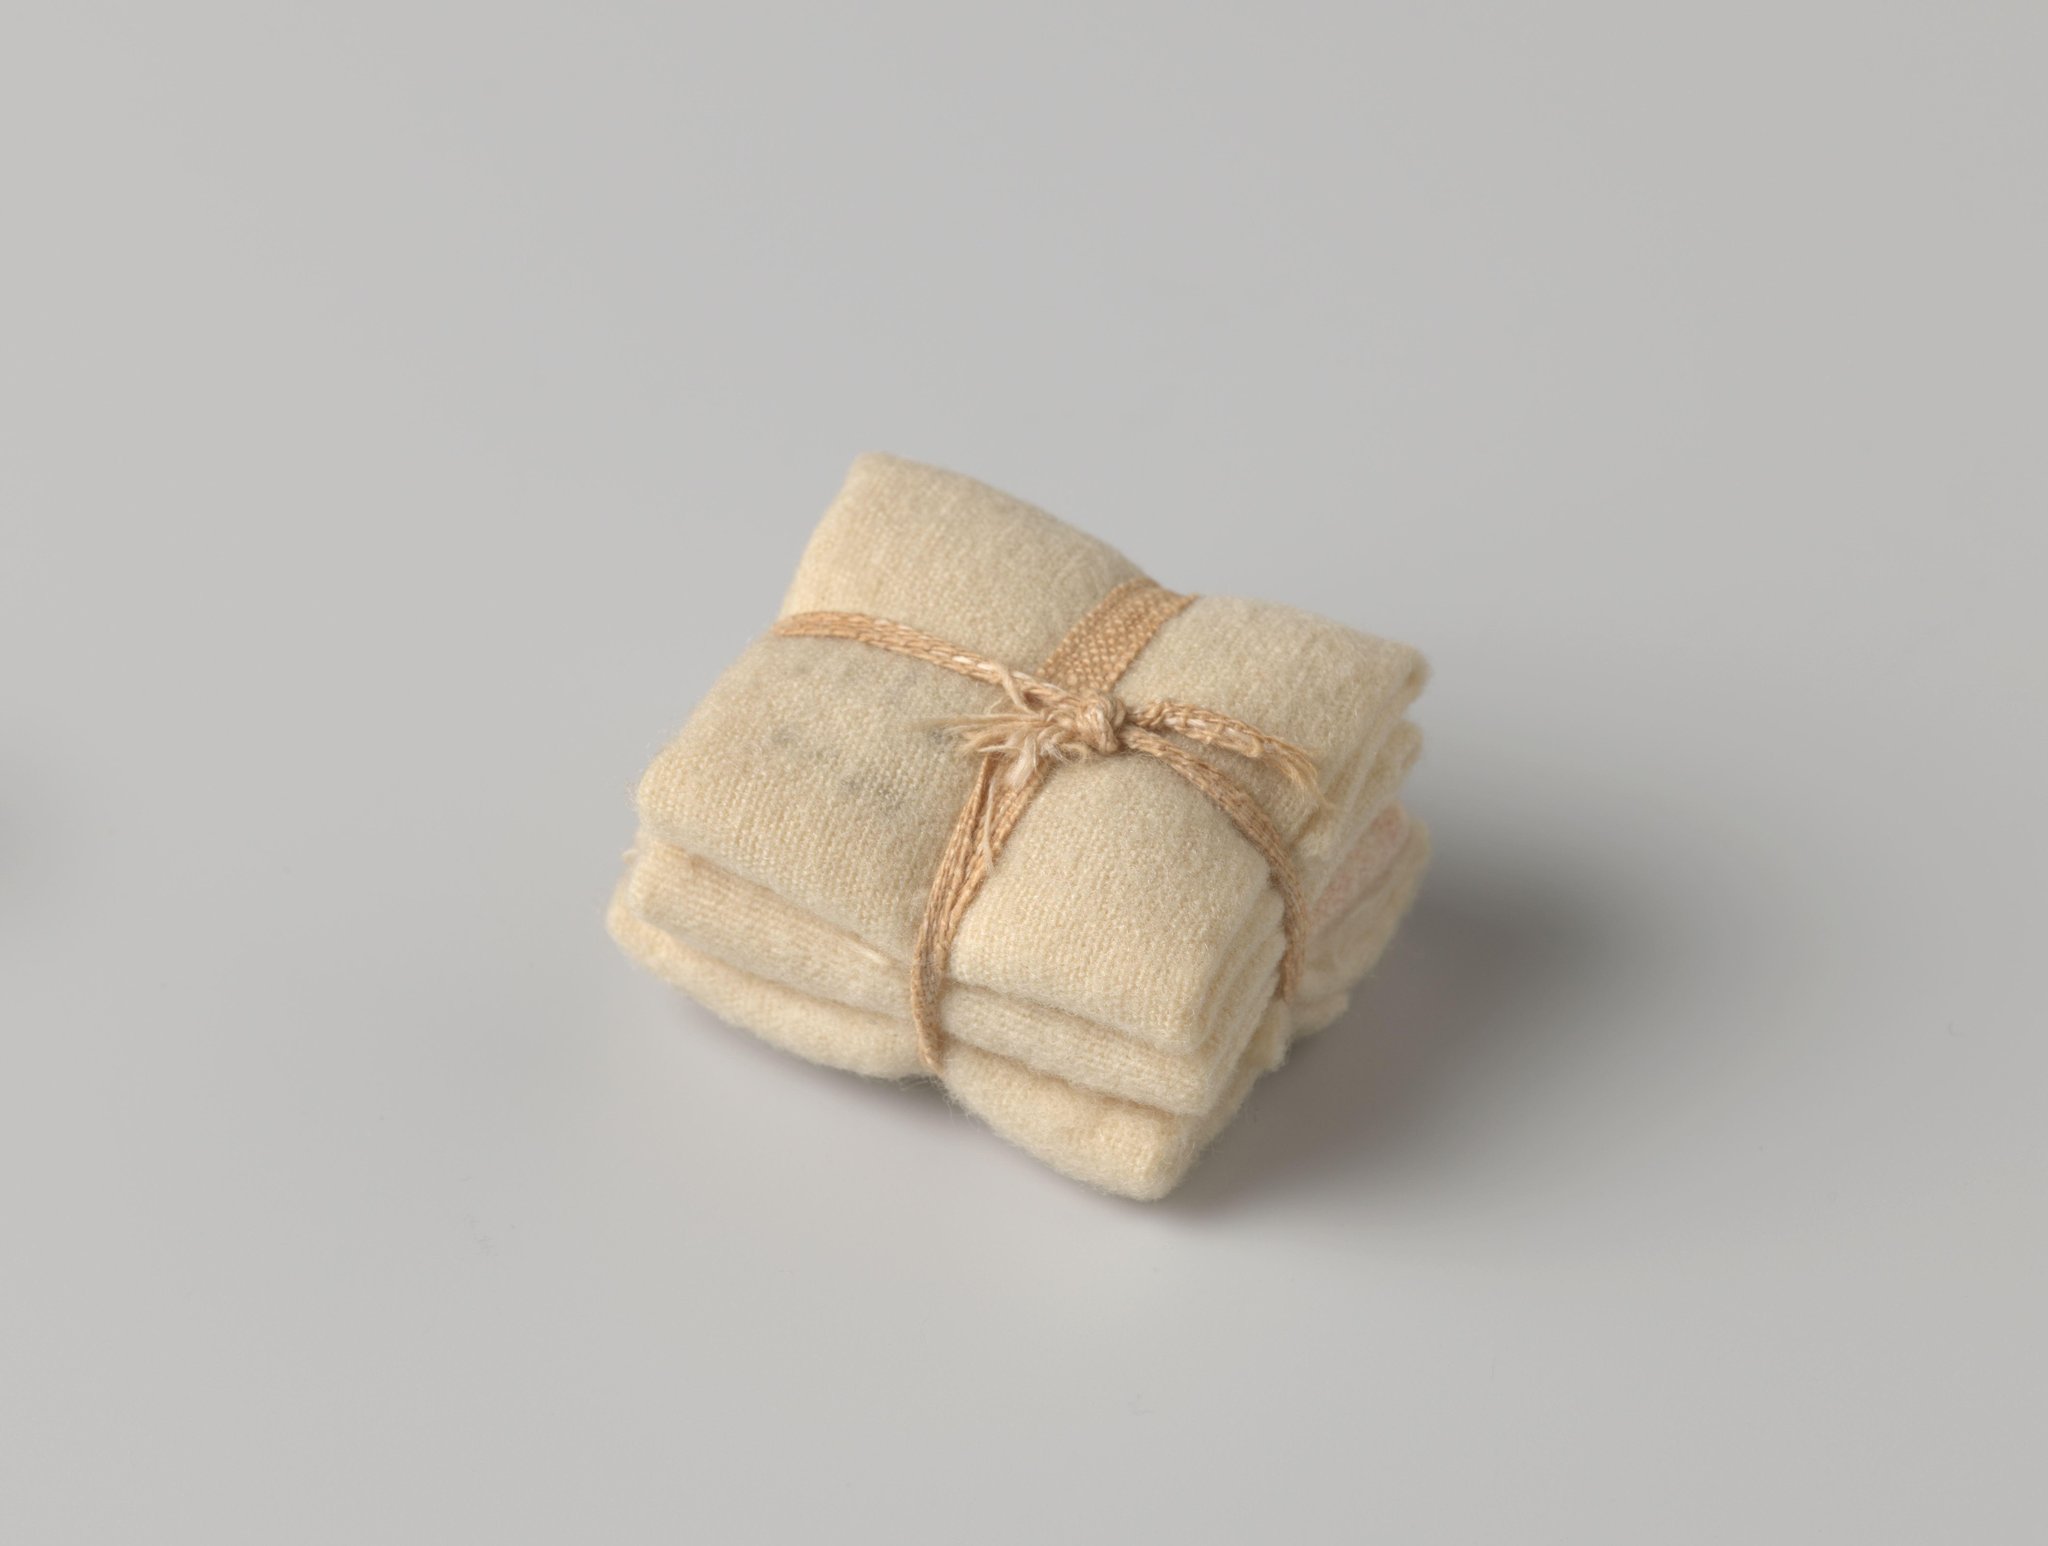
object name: blanket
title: Stapel dekens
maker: Anonymous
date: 1750-1800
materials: linen, wool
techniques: napping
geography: netherlands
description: Een stapel van drie opgevouwen en samengebonden wollen dekens (?) gebundeld met linnen band.